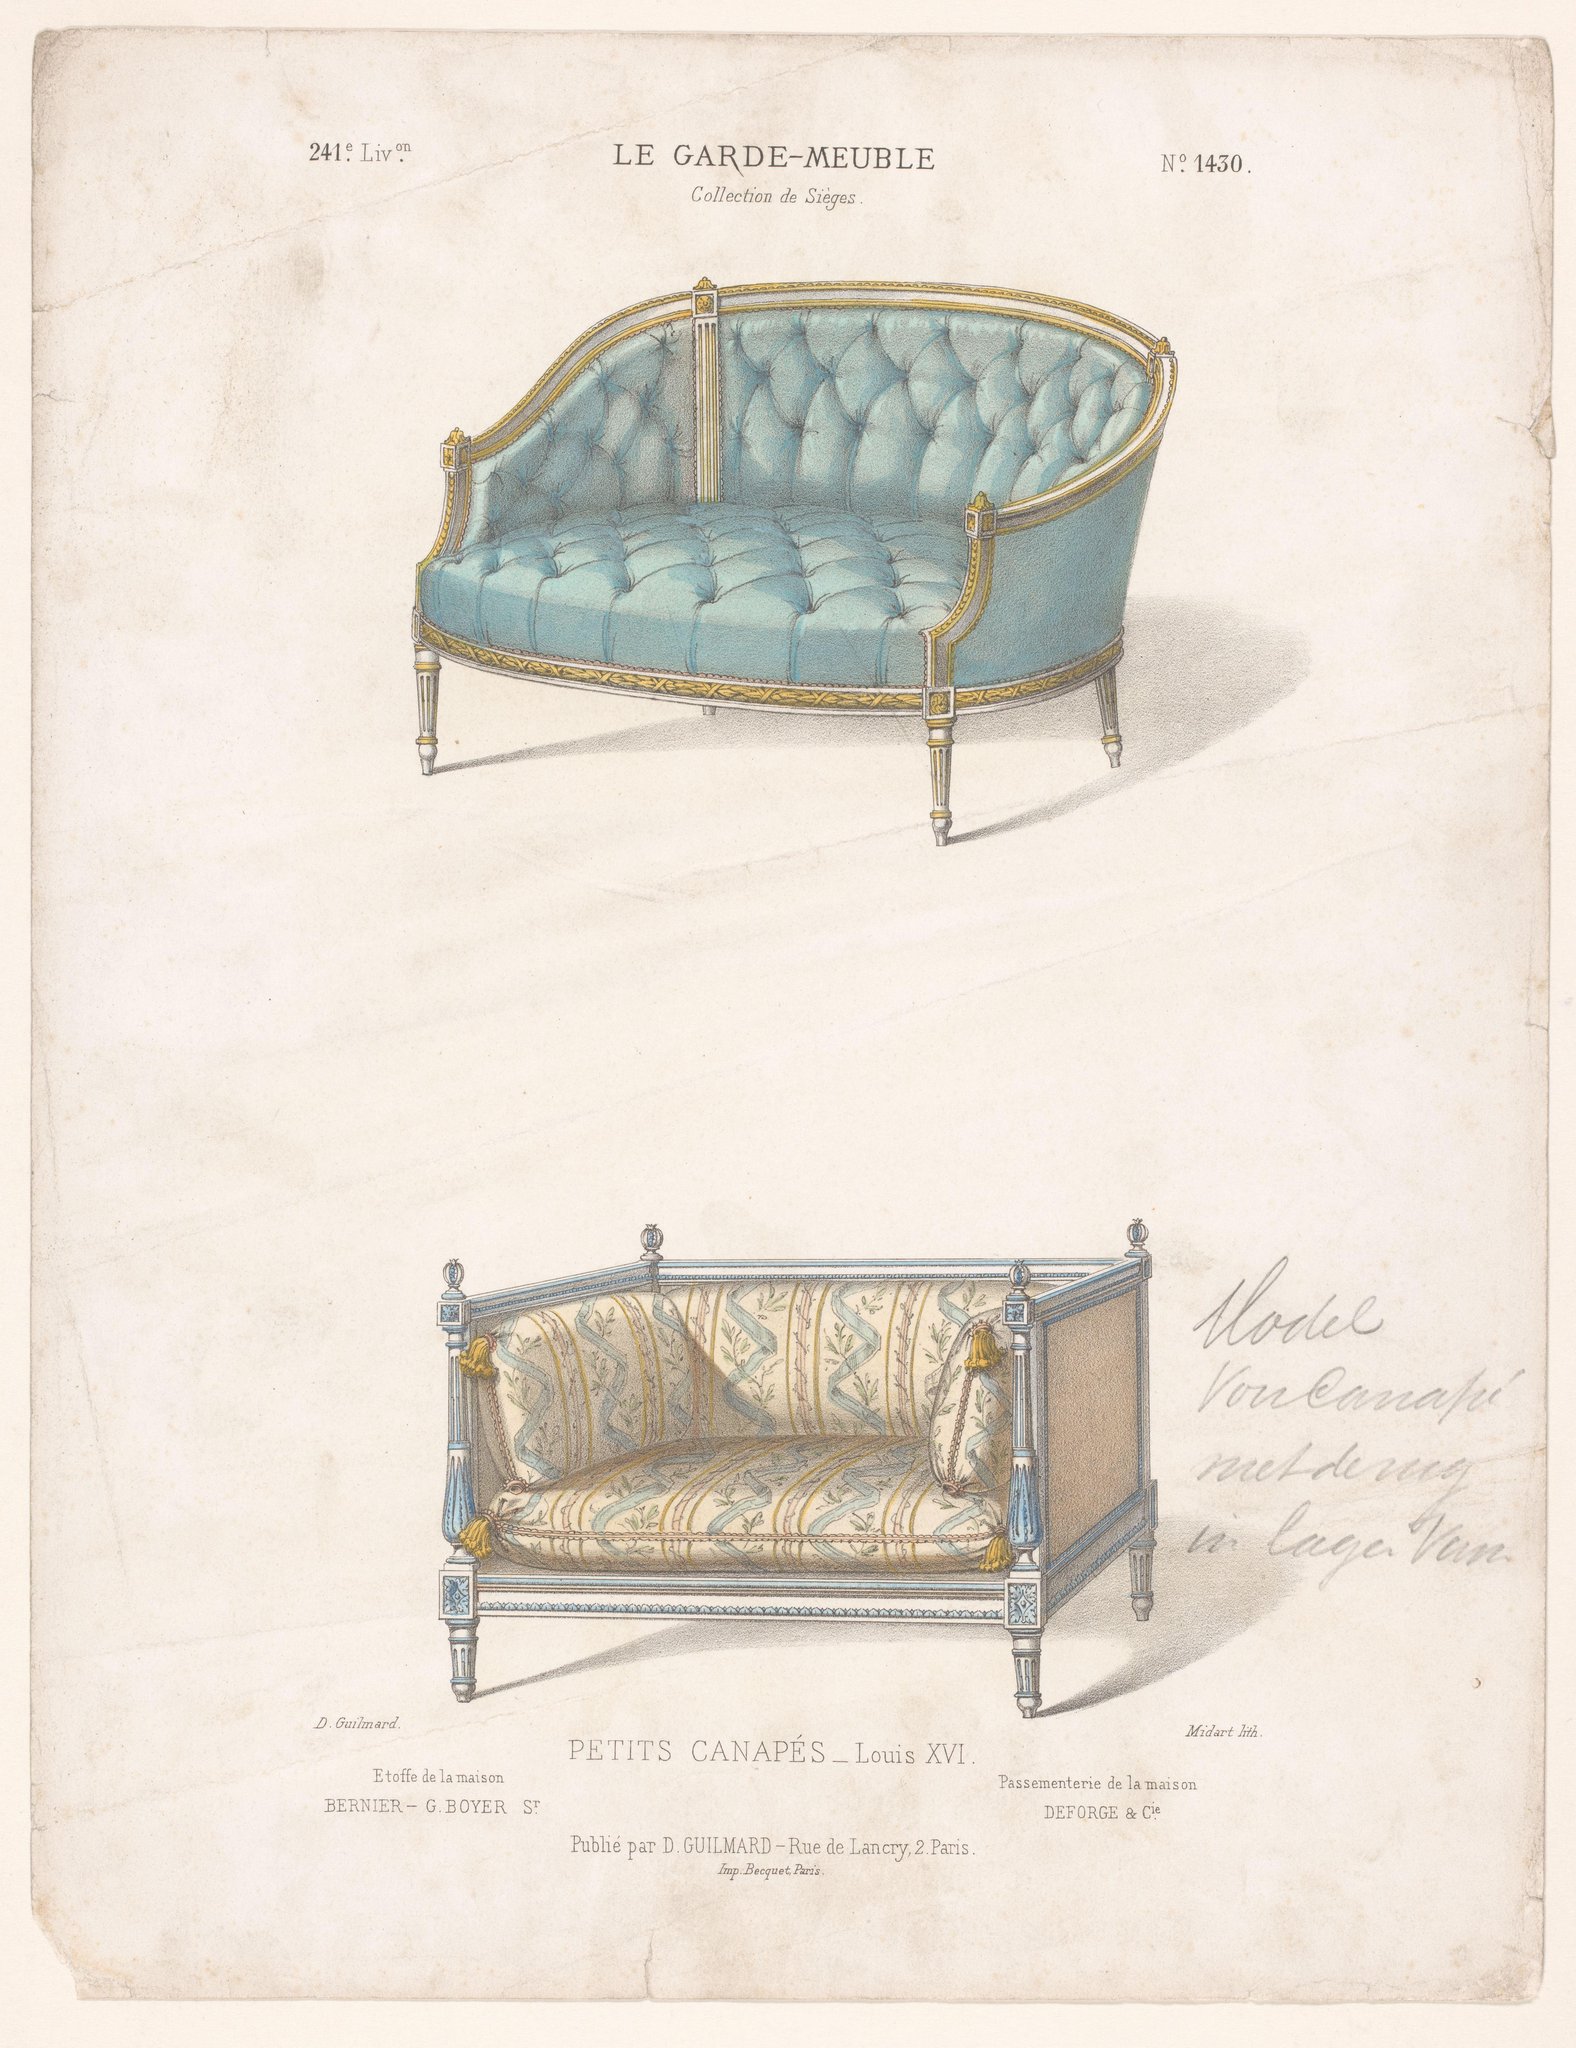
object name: print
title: Le garde-meuble / Collection de Sièges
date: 1839-1885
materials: paper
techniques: hand coloring, lithograph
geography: paris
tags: seating furniture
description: Ieder Livraison in de serie Le Garde-Meuble bevat negen platen: drie 'sièges' (zitmeubels), drie 'meubles' (diverse meubels zoals tafels en kasten) en drie 'tentures' (gordijnen en draperieën).